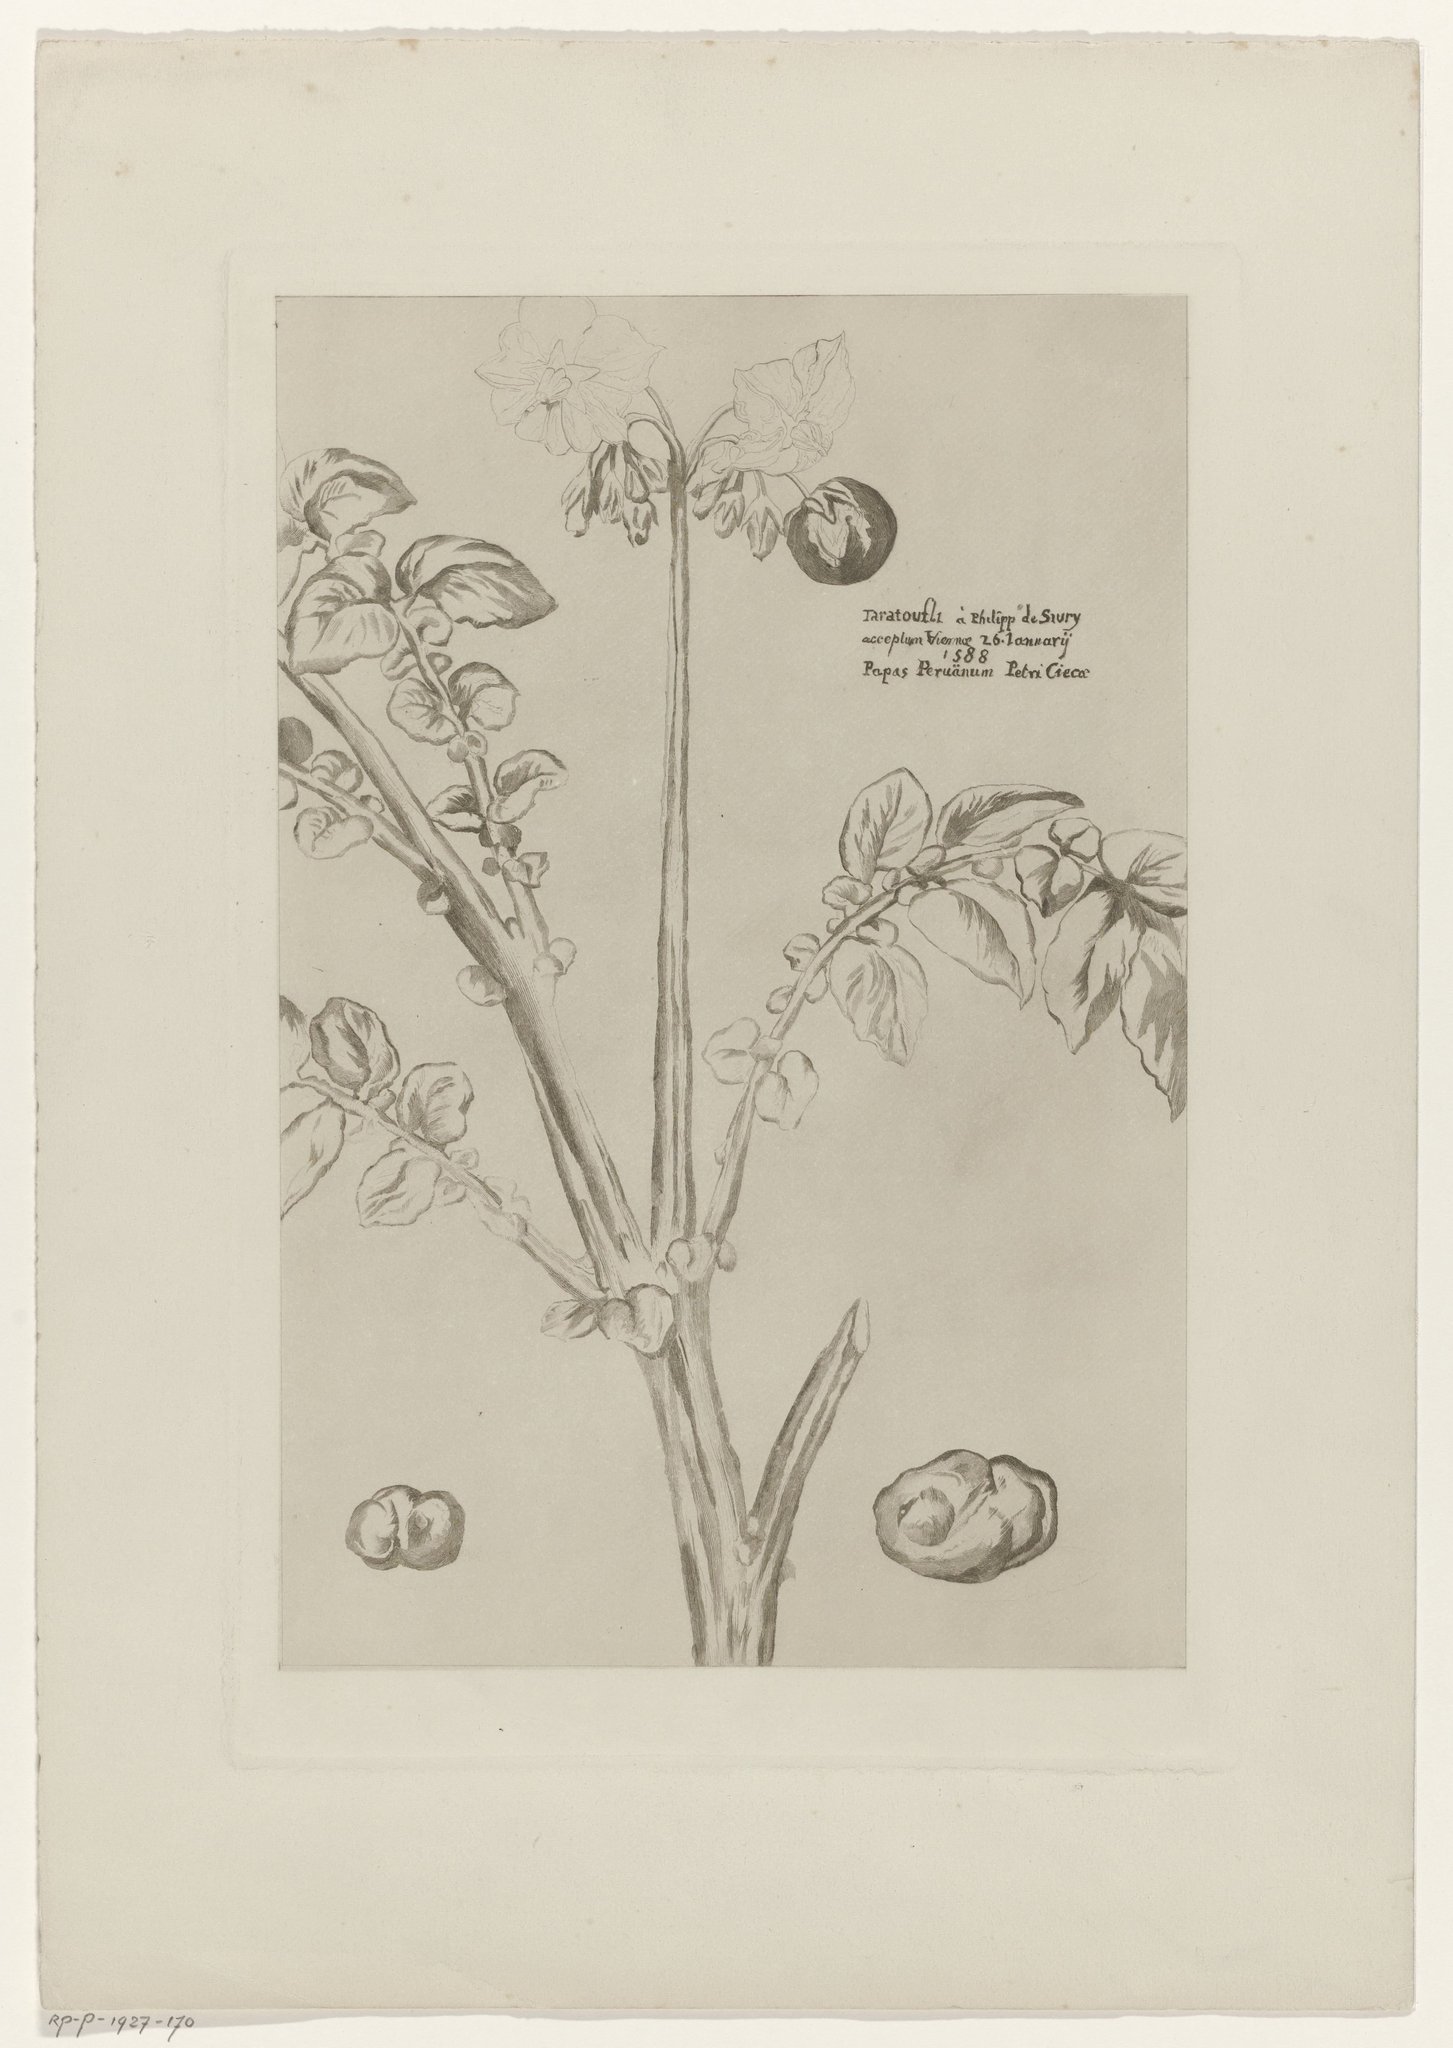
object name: print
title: Aardappelplant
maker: Anonymous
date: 1700-1900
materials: paper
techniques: etching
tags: leiden, plants cultivated for their edible roots or tubers, e.g. potato, turnip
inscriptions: collector's mark: Lugt 2233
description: Reproductie van de oudst bekende tekening van de aardappelplant met daarnaast twee aardappels. Philippe de Sivry stuurde deze tekening van zijn aardappelplant naar Clusius in 1588.